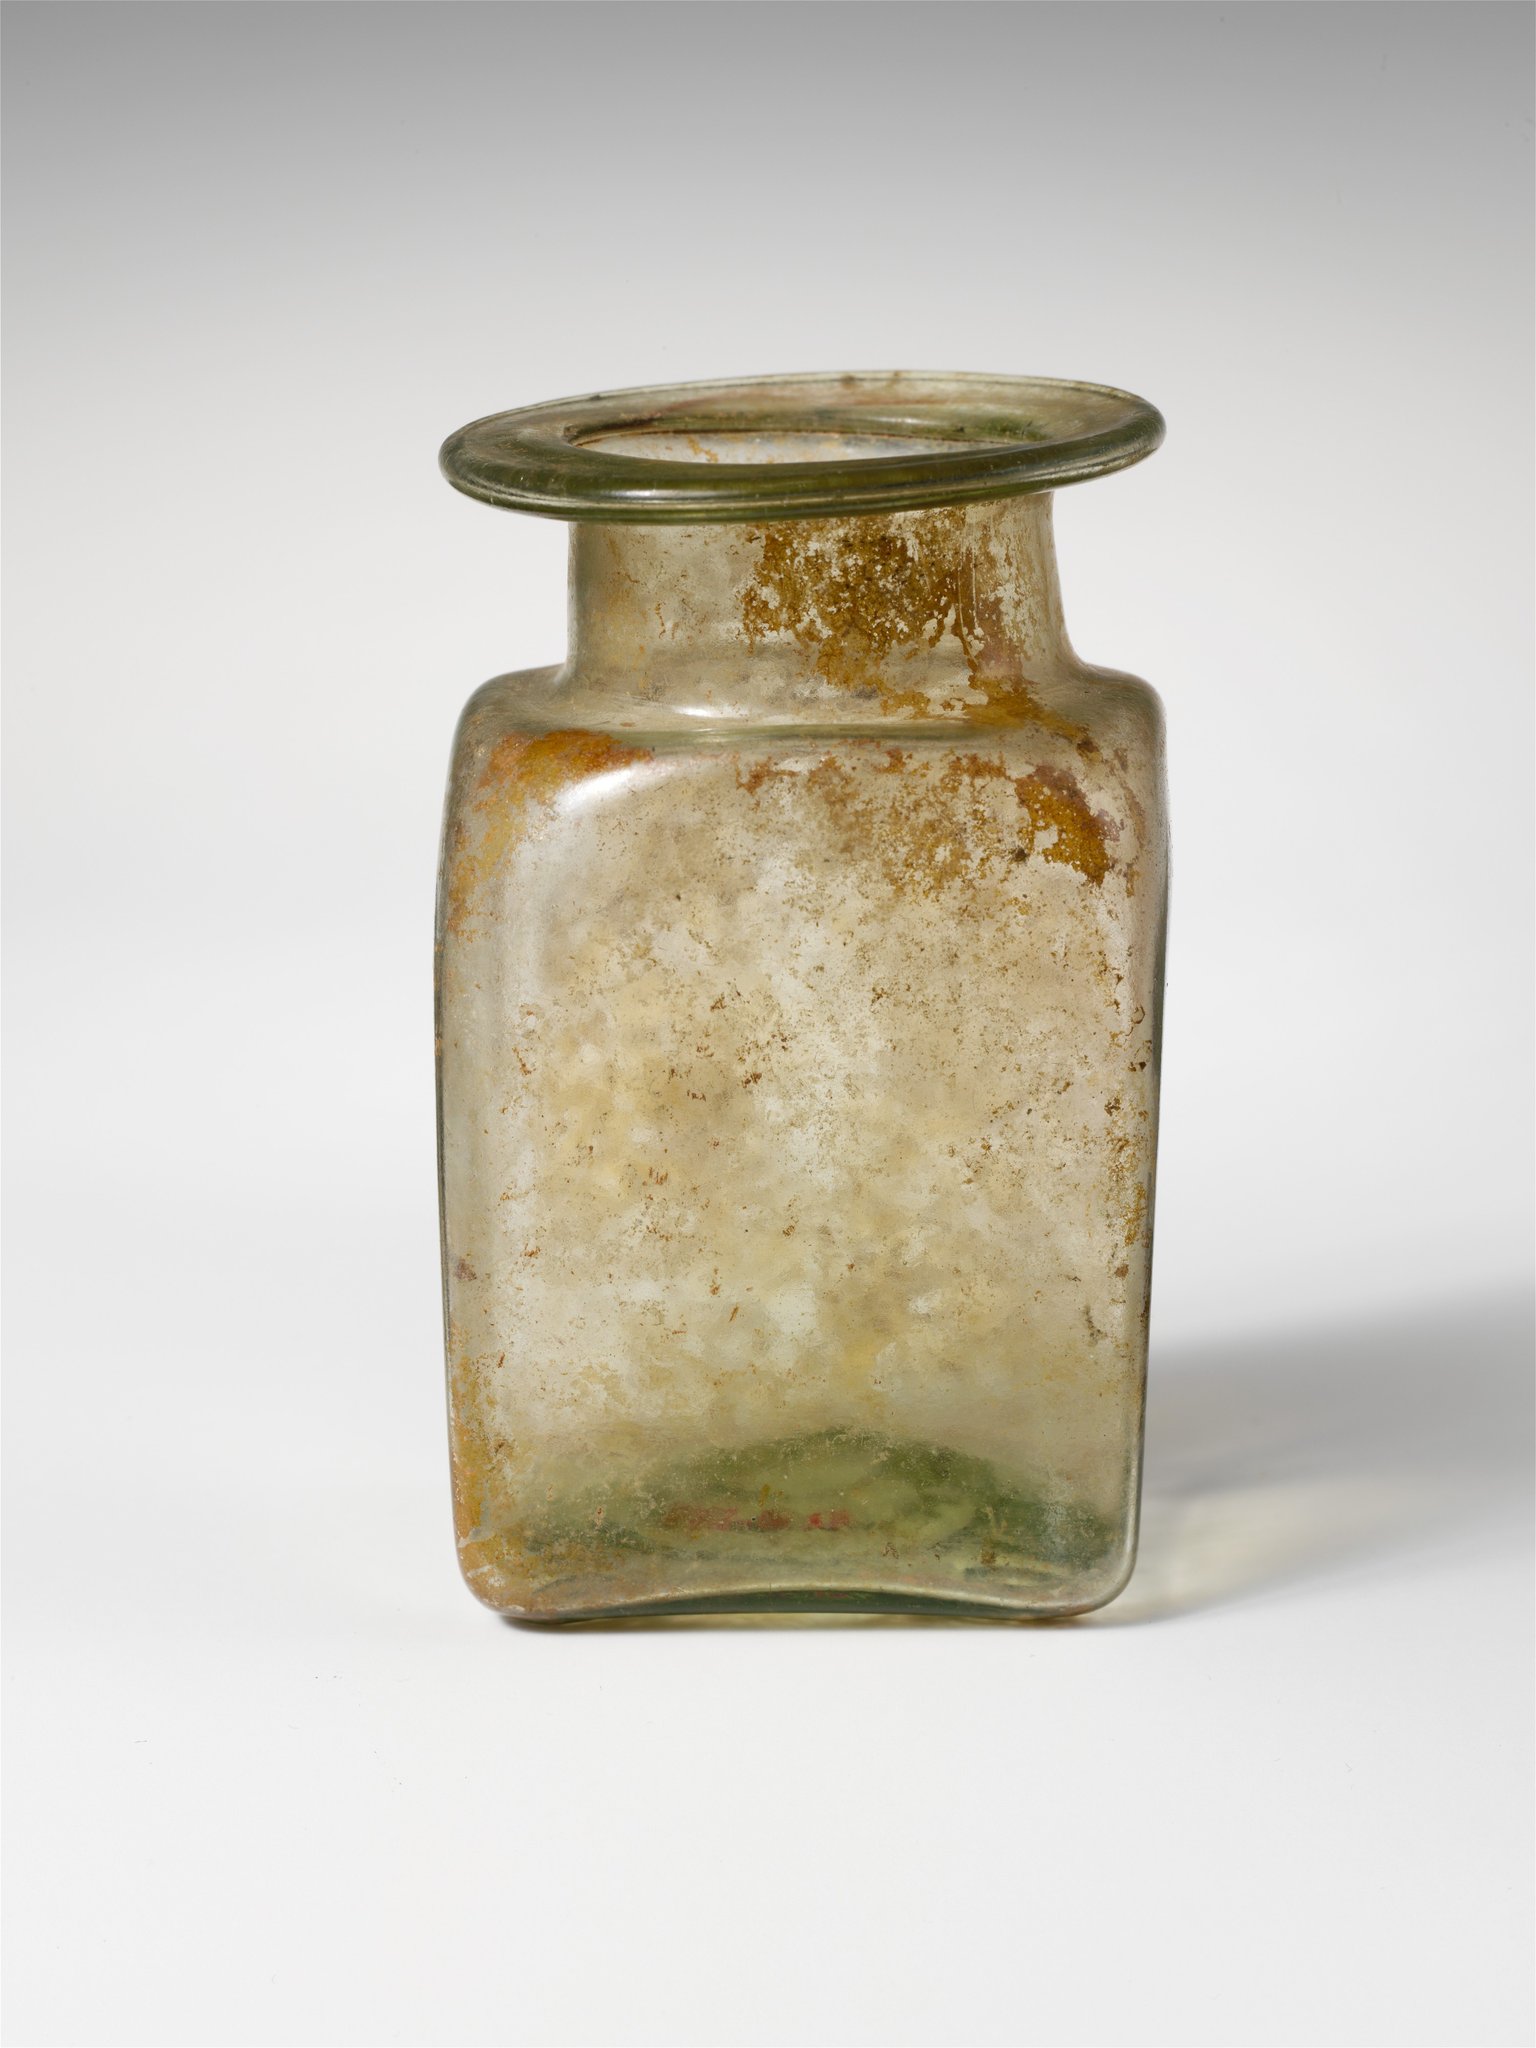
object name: jar, square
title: Glass square jar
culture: roman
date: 101-300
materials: glass